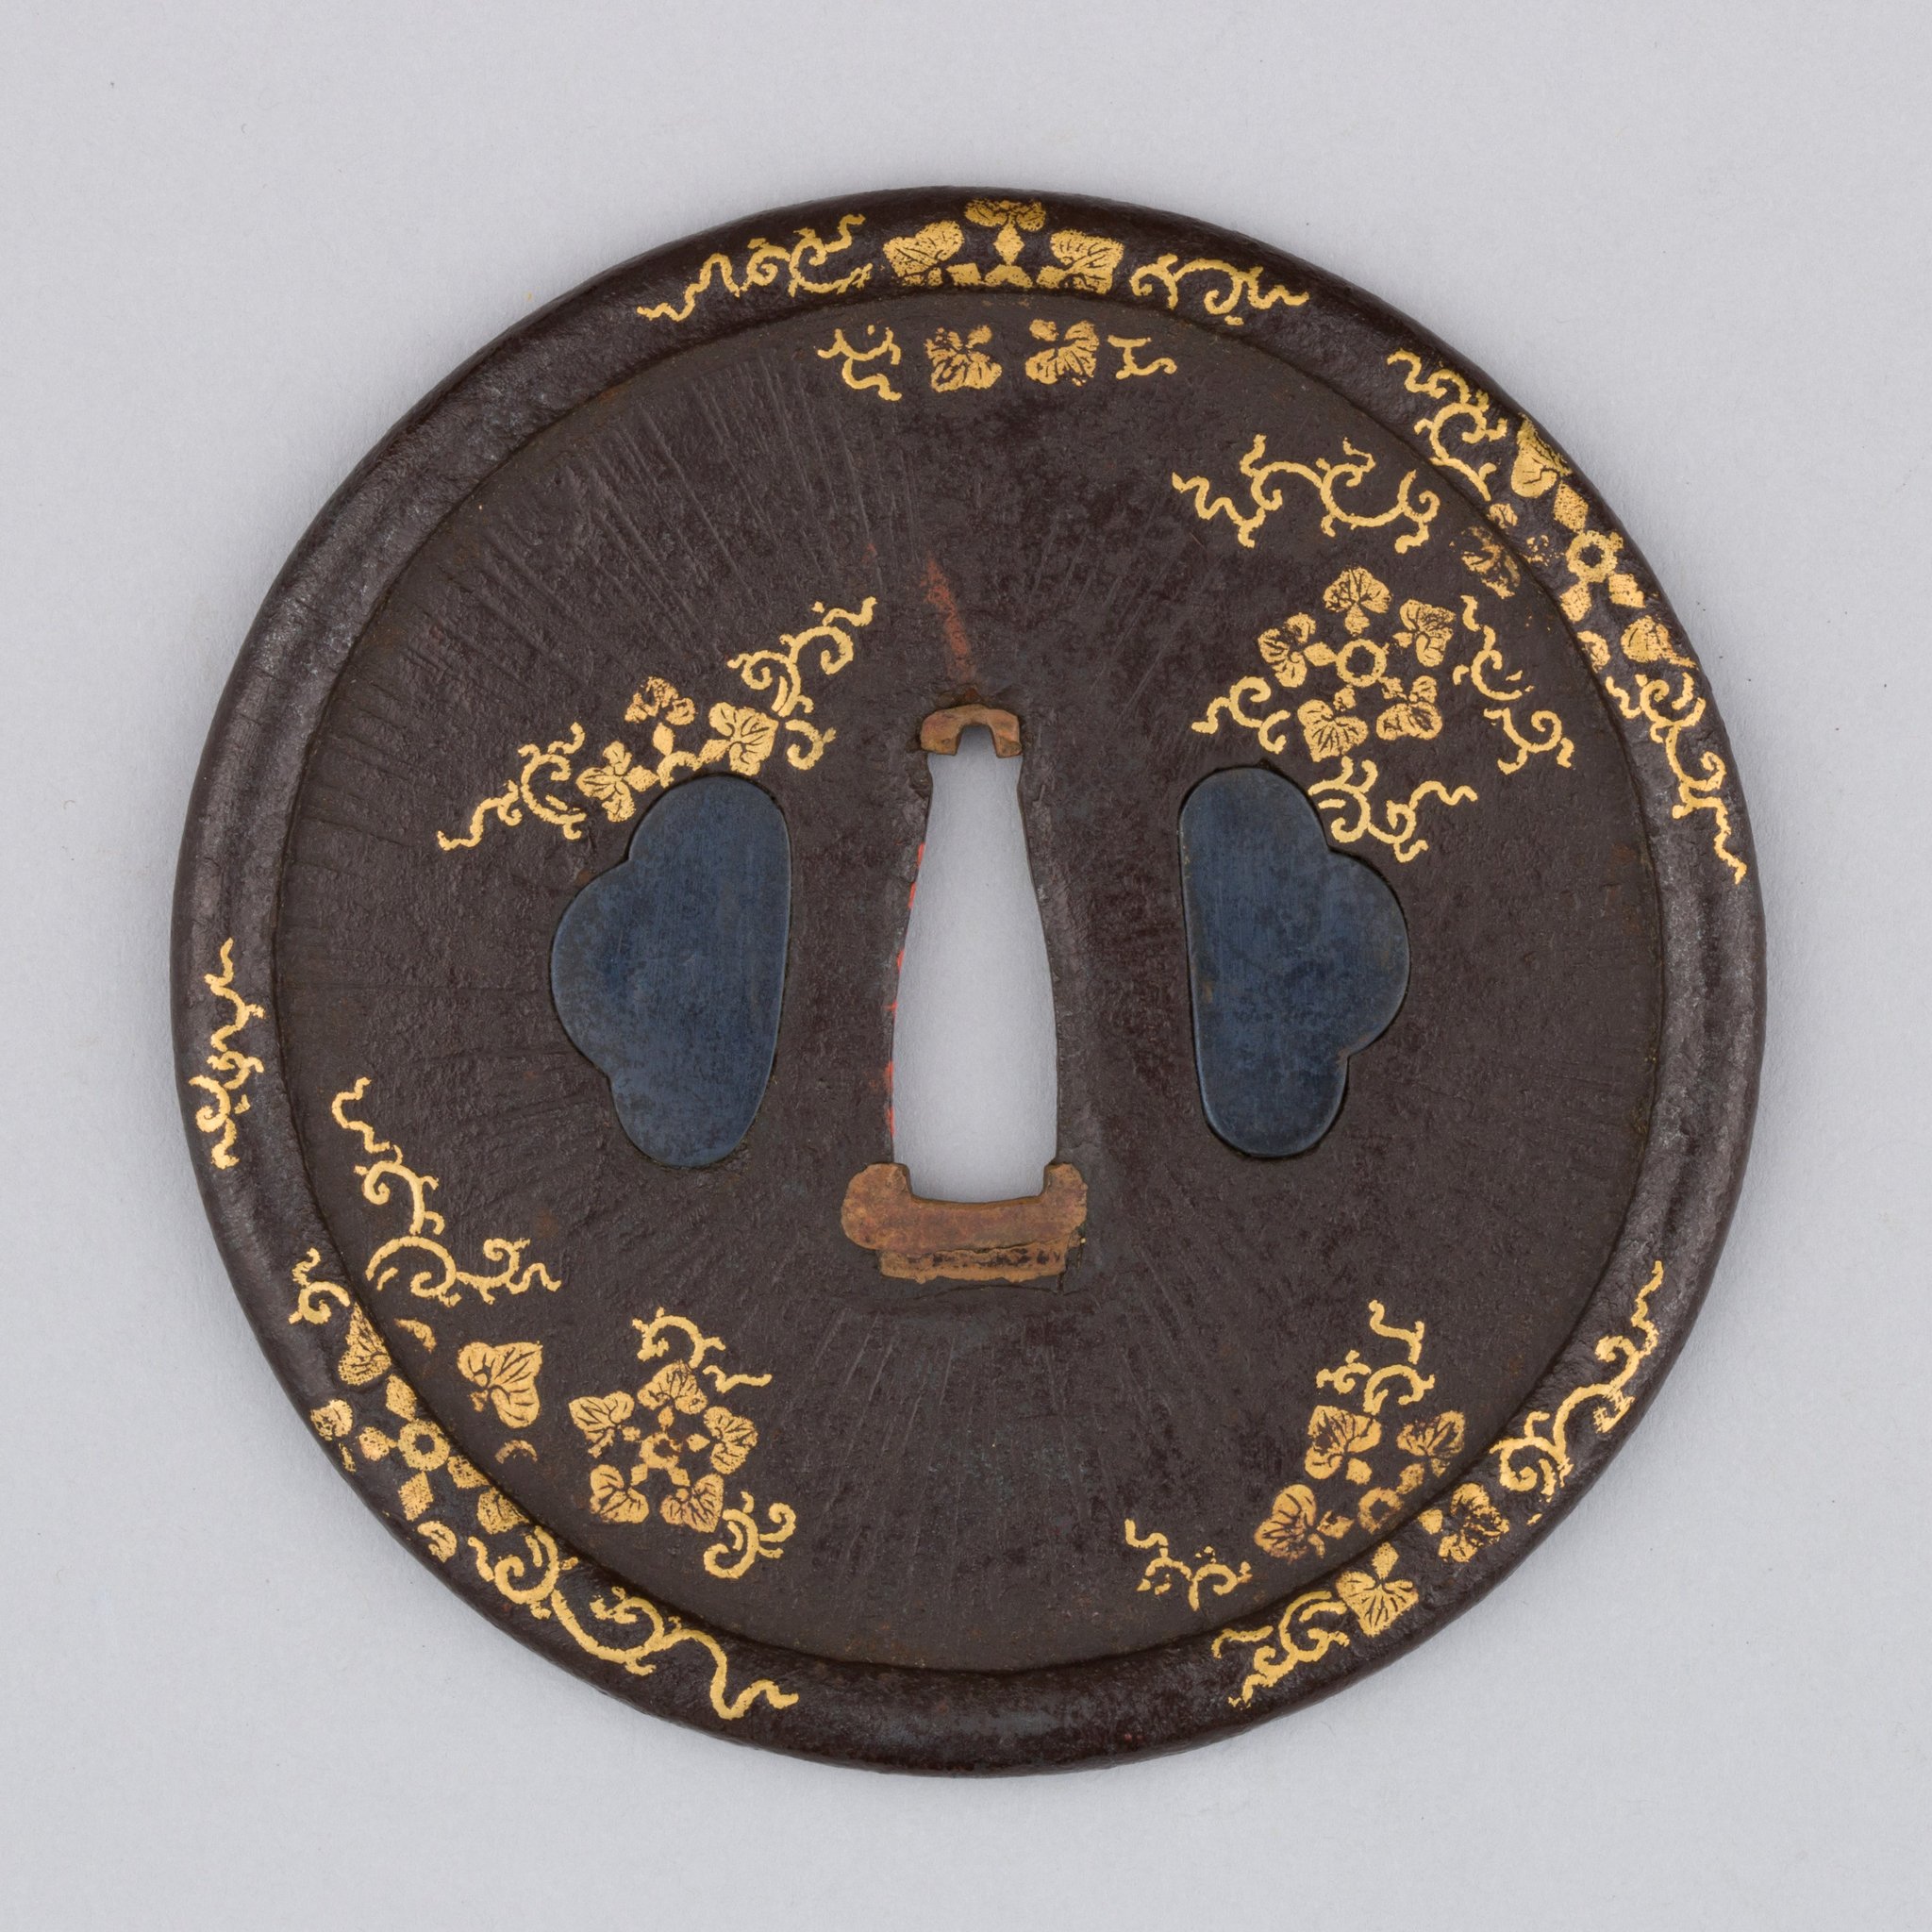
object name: sword guard tsuba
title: Sword Guard (Tsuba)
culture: japanese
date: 1701-1800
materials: copper, gold, iron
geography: japan